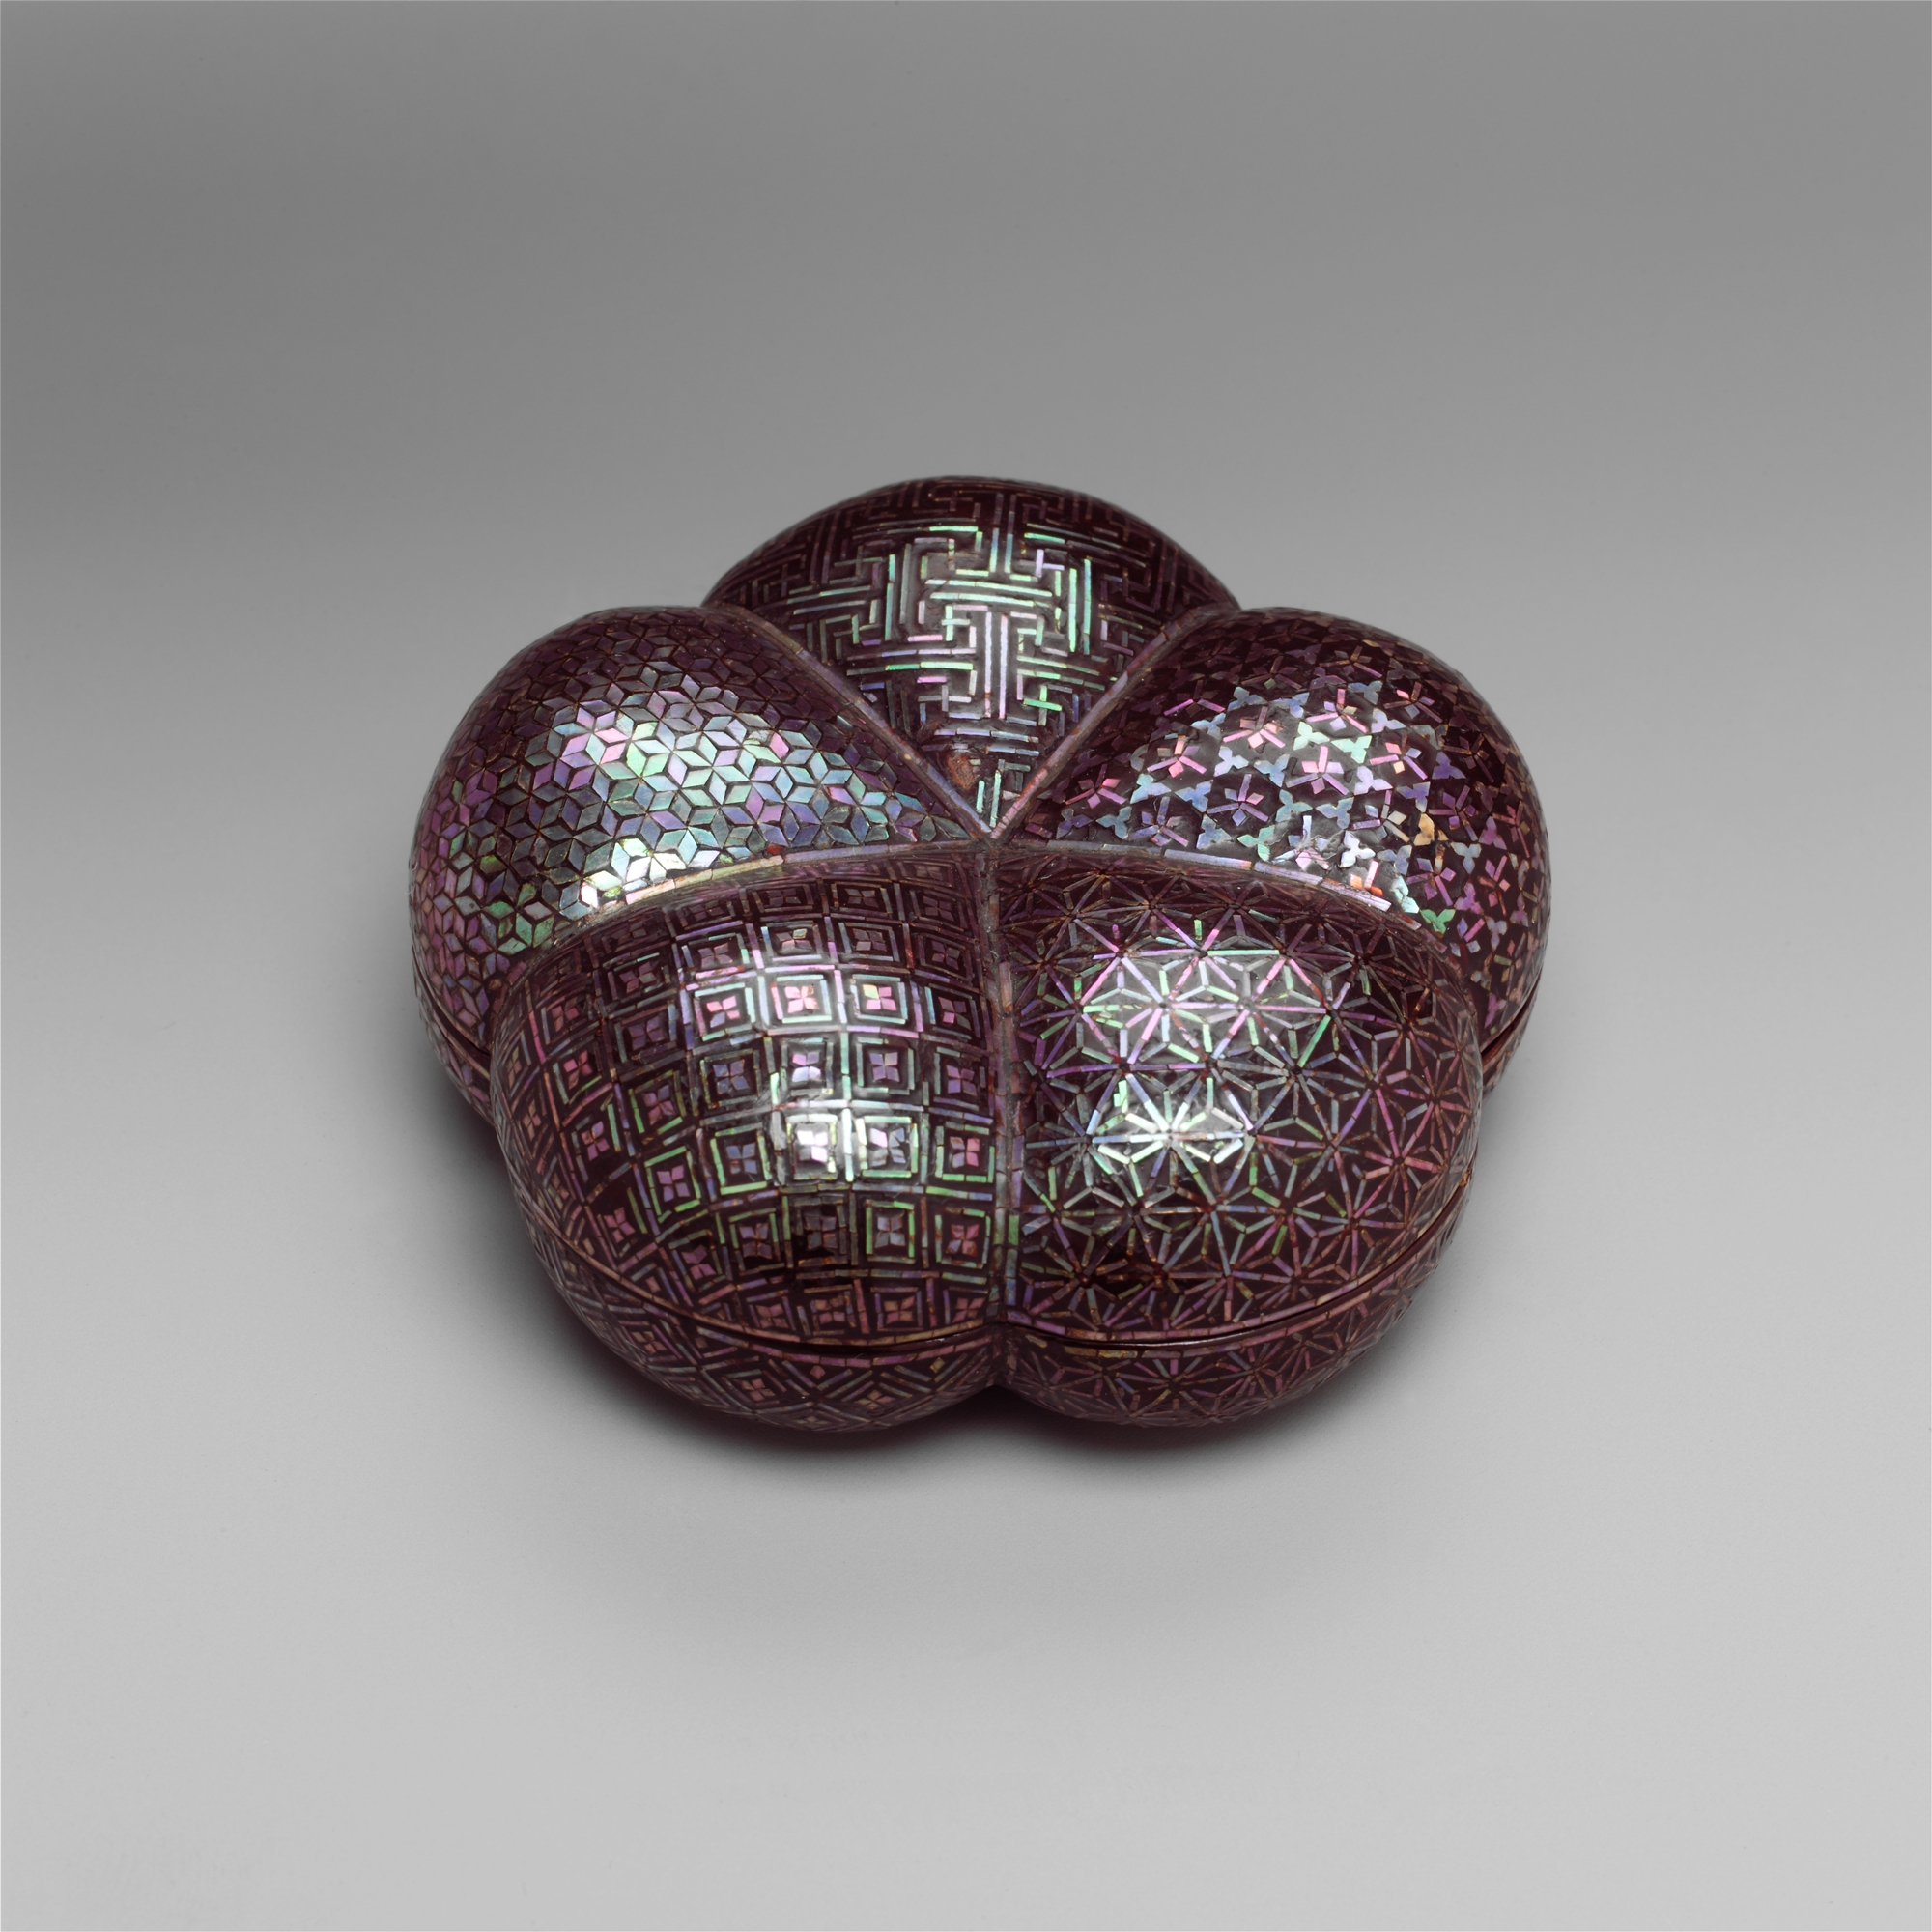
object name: box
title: Box with Geometric Designs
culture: chinese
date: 1667-1700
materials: lacquer, mother of pearl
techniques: inlay